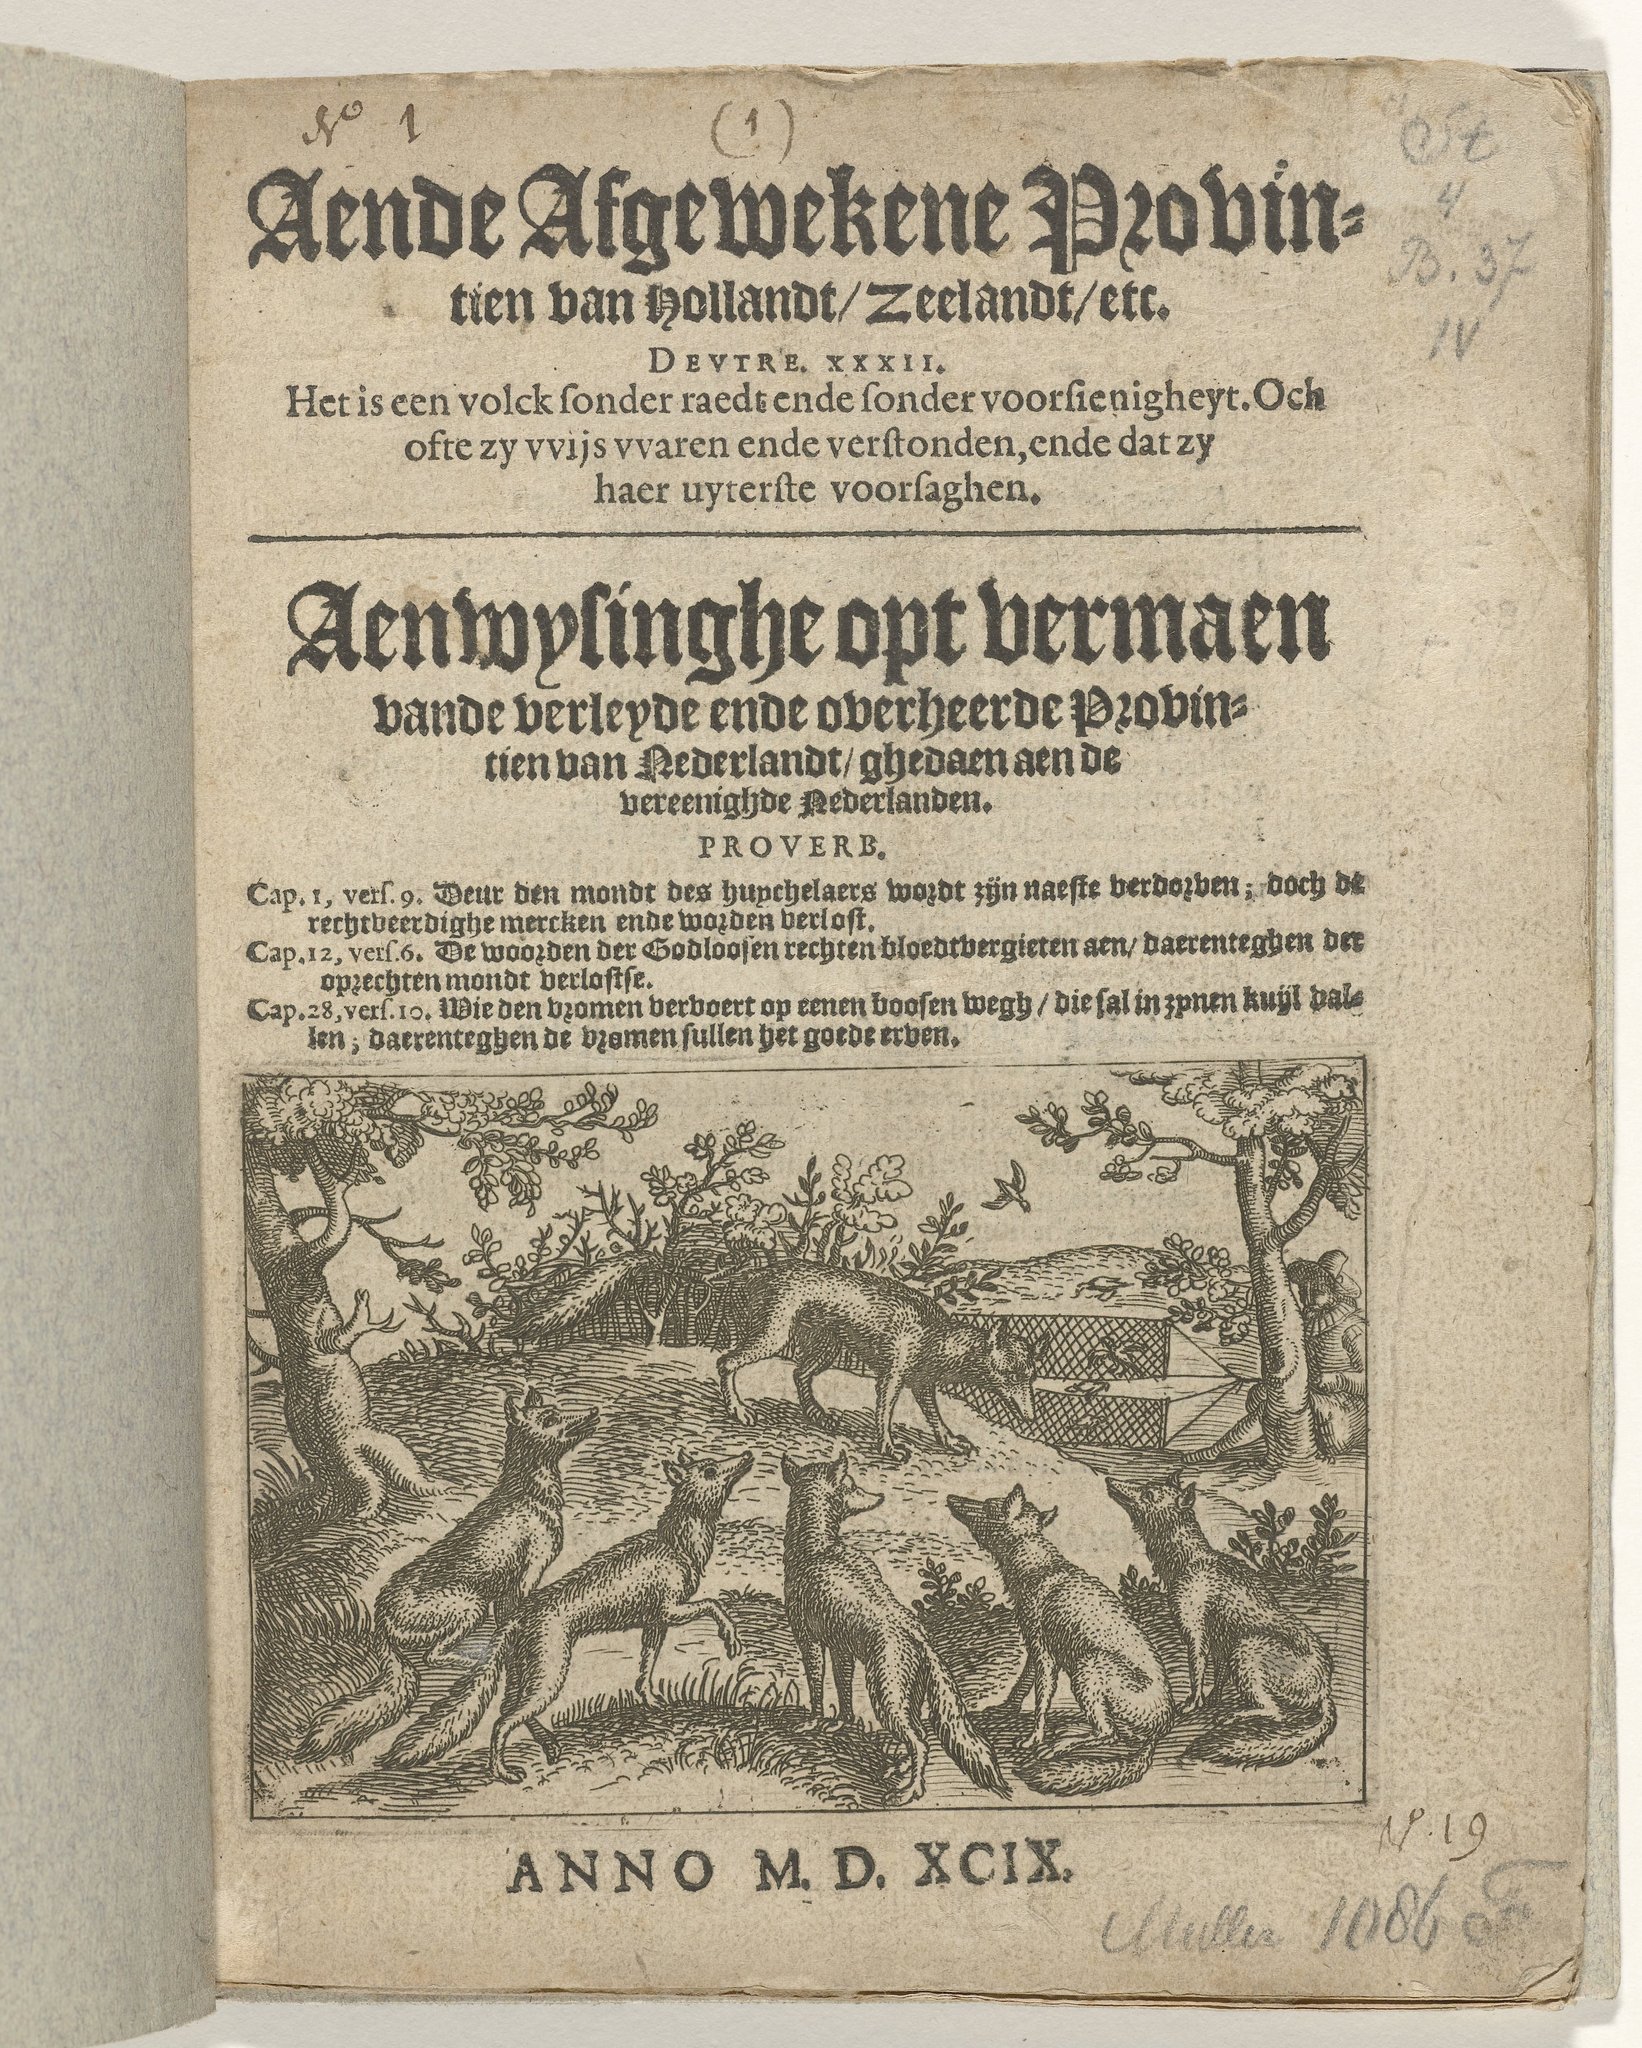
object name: cartoon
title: Titelpagina van het pamflet: Aende Afgewekene Provintien van Hollandt, Zeelandt, etc. / Aenwysinghe opt vermaen vande verleyde ende overheerde Provintien van Nederlandt, ghedaen aen de vereenighde Nederlanden, 1599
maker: Anonymous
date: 1599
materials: paper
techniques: etching, letterpress printing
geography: northern netherlands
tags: albrecht aartshertog van oostenrijk, title-page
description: Spotprent met de gevangen vos en de vrije vossen. Spotprent op de Spaanse vredesvoorstellen van Albrecht aan de Staten-Generaal, augustus 1598. Titelprent van een pamflet getiteld: Aende Afgewekene Provintien van Hollandt, Zeelandt, etc. / Aenwysinghe opt vermaen vande verleyde ende overheerde Provintien van Nederlandt, ghedaen aen de vereenighde Nederlanden. Een vos wiens staart in de klem vast zit raadt vijf andere vossen aan ook hun staart te verliezen; een als metafoor voor de situatie waarin de Spaanse Nederlanden verkeren.